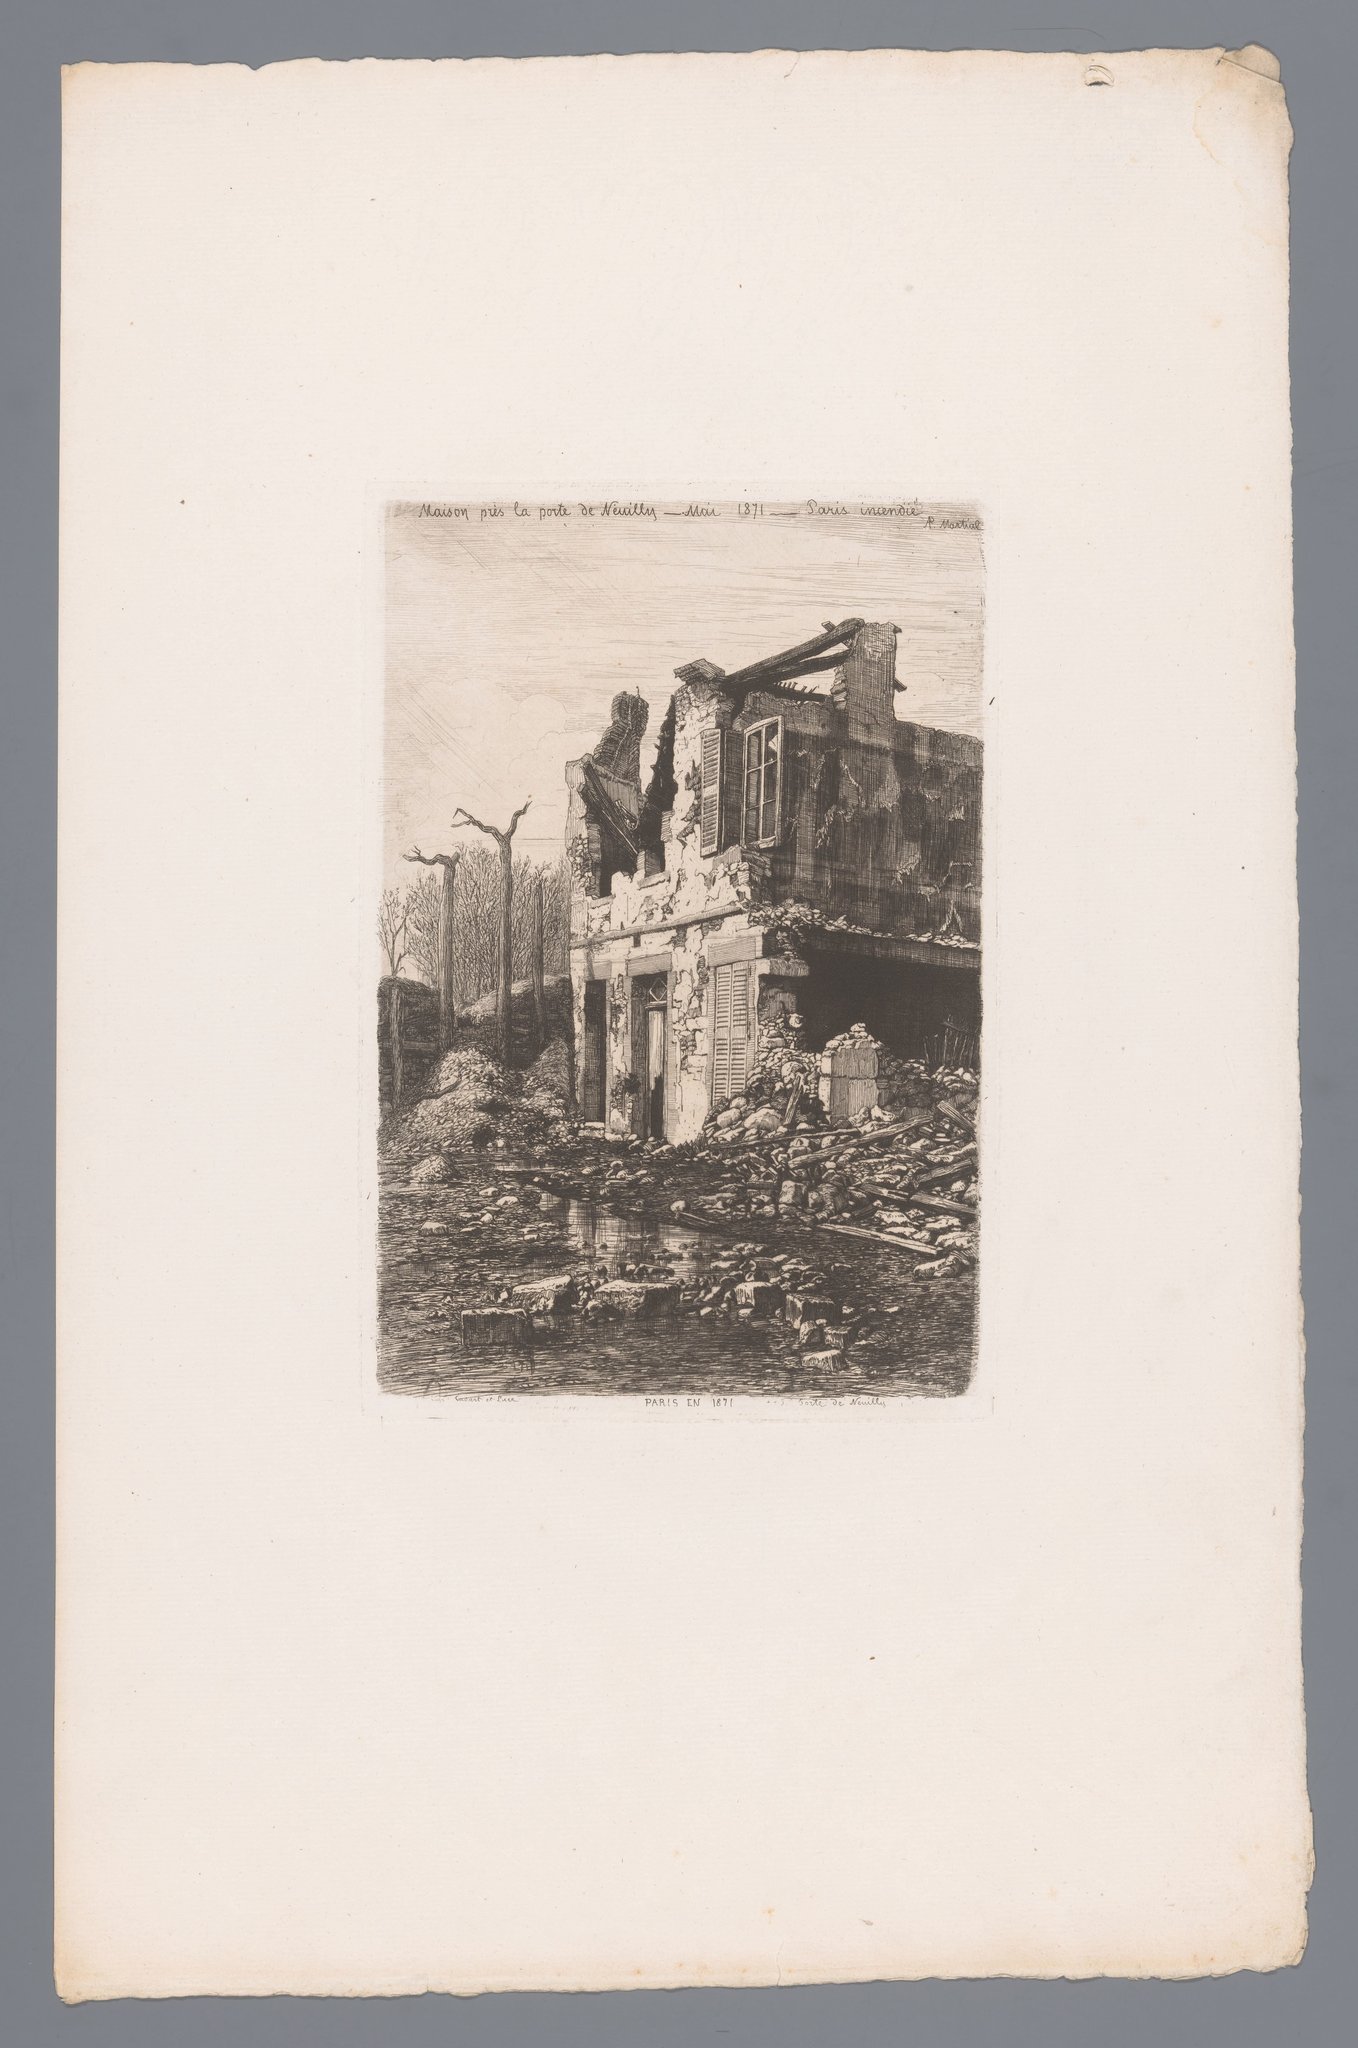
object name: print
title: Parijs in brand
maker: adolphe martial potémont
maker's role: print maker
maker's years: 1828-1883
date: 1871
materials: paper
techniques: etching, intaglio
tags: ruin of a building ~ architecture, paris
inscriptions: collector's mark: Lugt 2228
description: De prent bevindt zich in een omslag en maakt deel uit van een twaalfdelige serie prenten met als onderwerp het brandende Parijs tijdens de Commune in 1871, samengesteld en uitgevoerd door Martial Potémont.